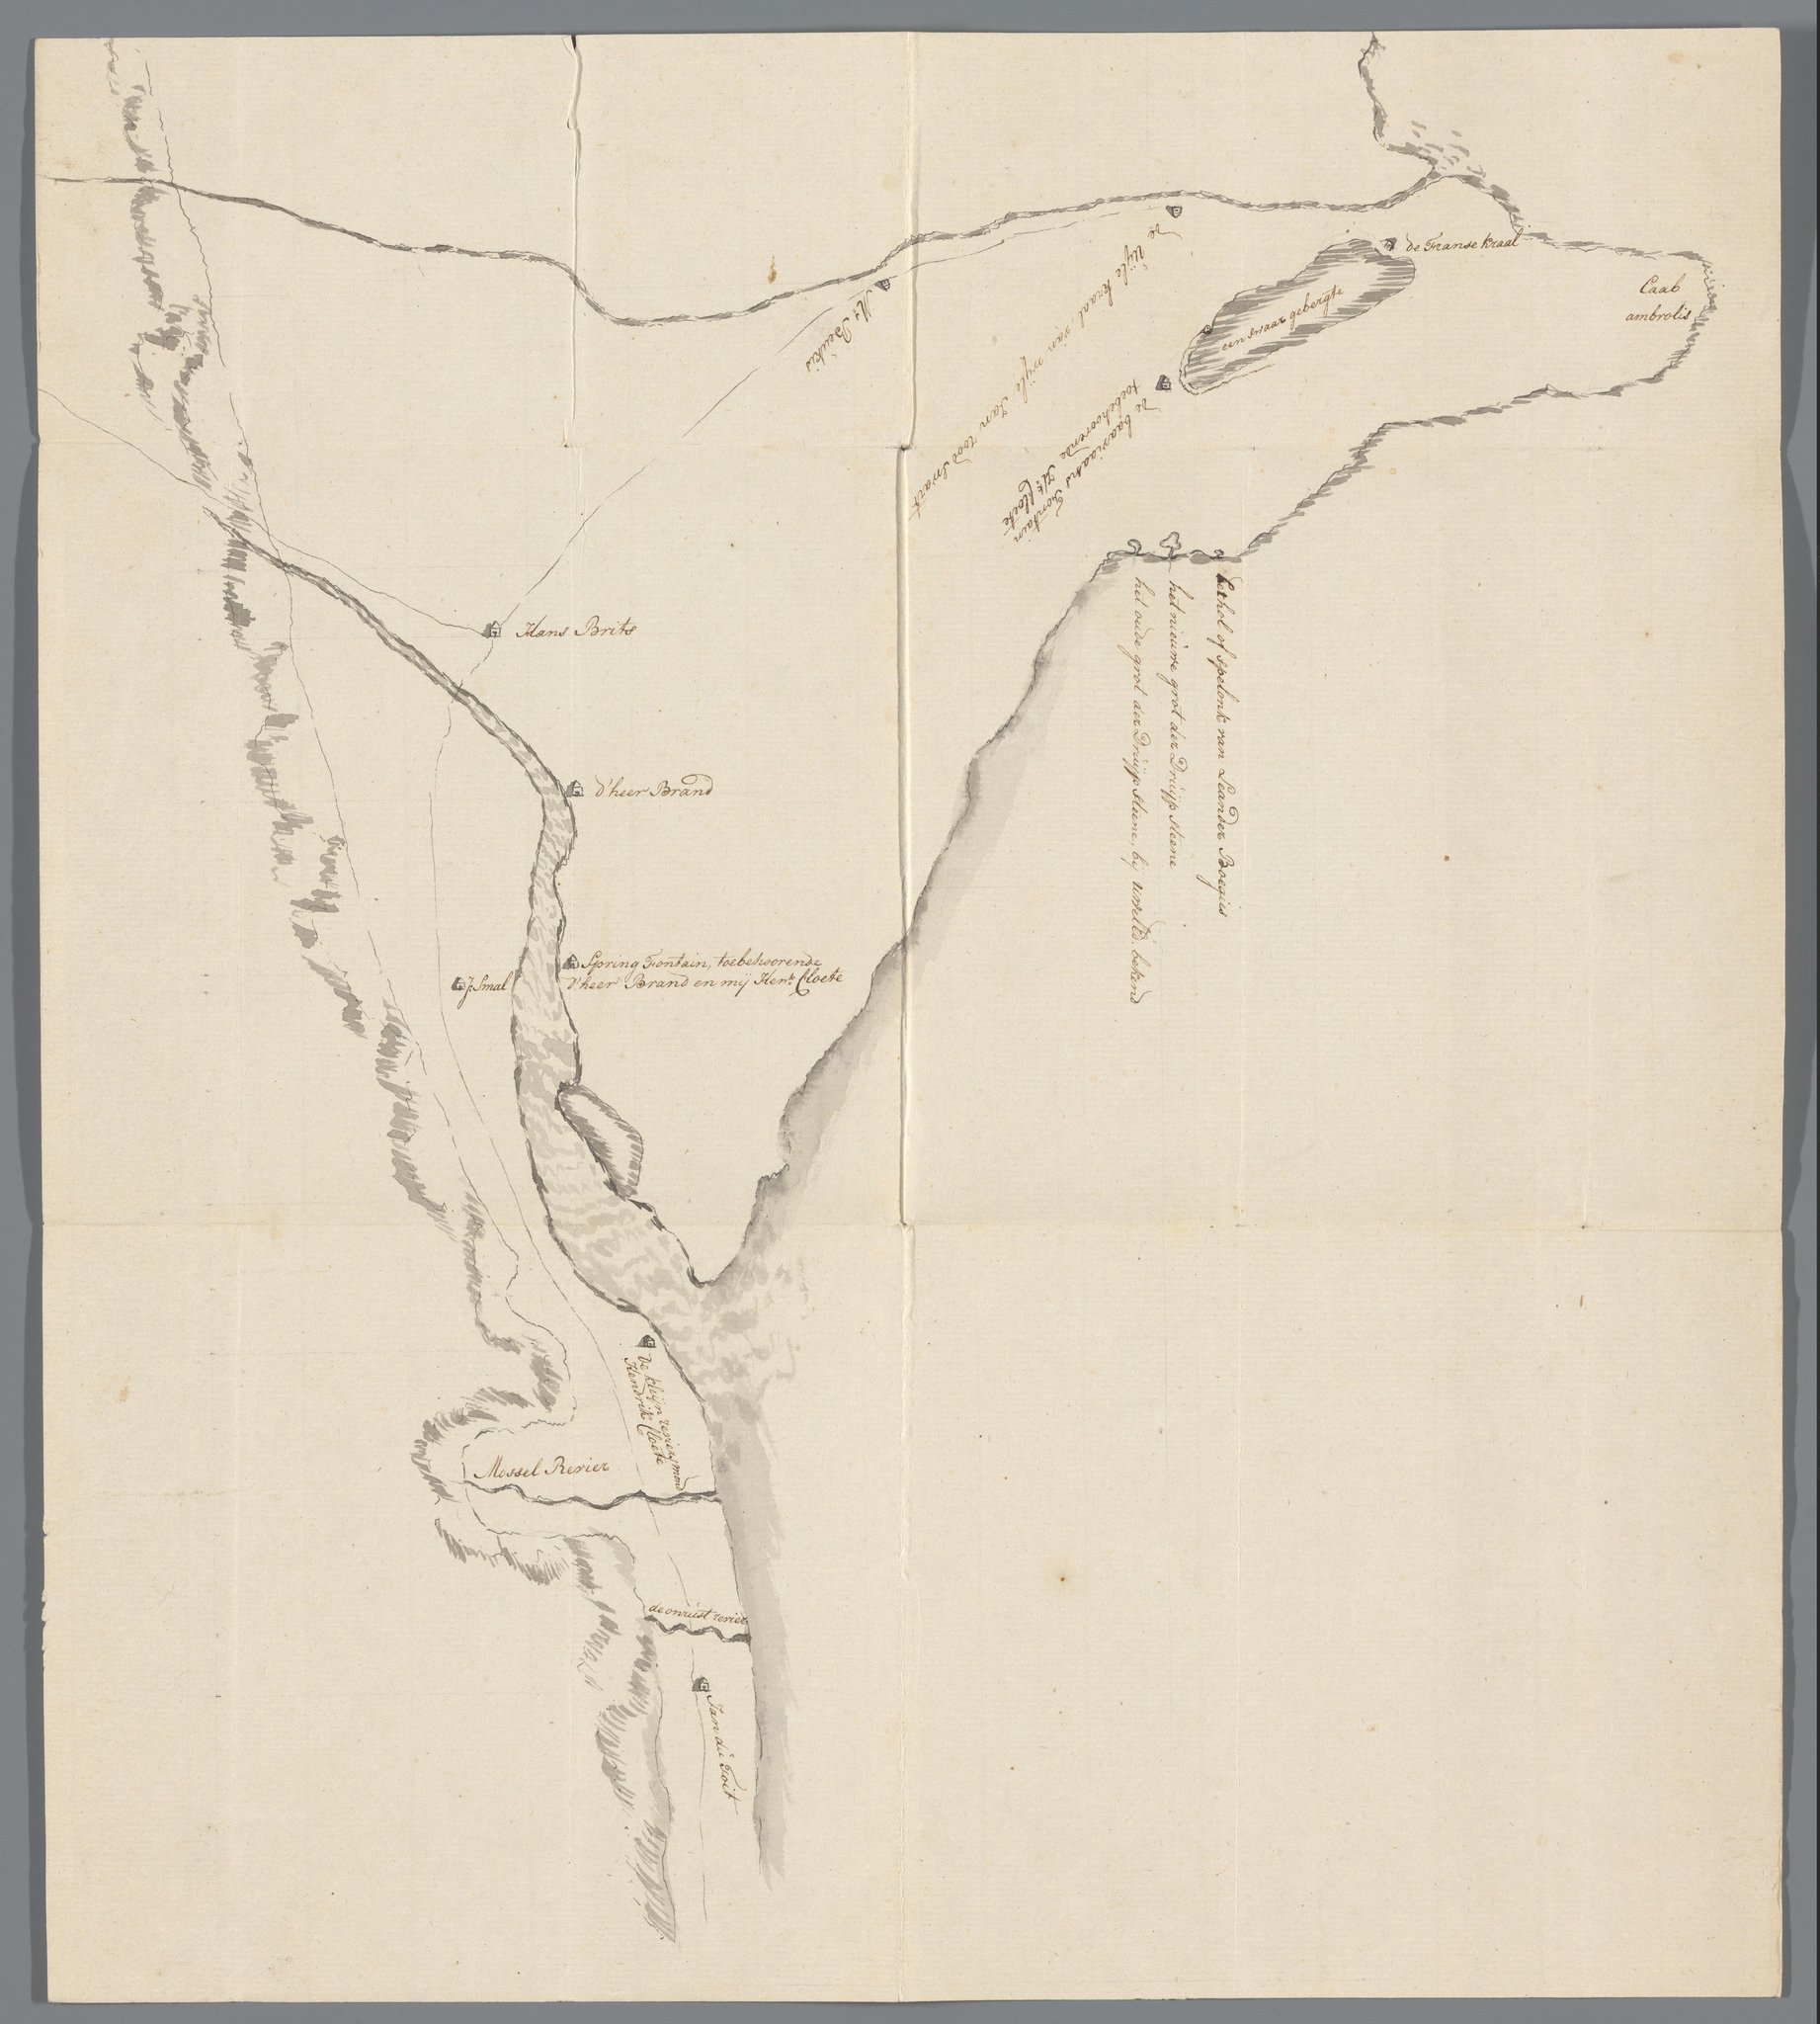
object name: drawing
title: Onderstaande is het terrein alwaar het oude Hospitaal op gestaan heeft verdeeld in 10 Huijs Erven en op 1 August 1786 (...)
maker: Anonymous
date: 1780-1799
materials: ink, paper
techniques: brush, pen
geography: south africa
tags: maps of separate countries or regions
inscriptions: label: ‘A9’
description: Getekende kaart van het kustlandschap bij het tegenwoordige Hermanus, ten oosten van Kaapstad. Op de kaart staan aangegeven namen van boerderijen, rivieren, etc. Enkele plaatsten verworven door Hendrik Cloete vanaf 1778, zoals Baviaansfontein en het terrein bij de monding van de Kleine Rivier en de Mosselrivier. Bovenaan de druipsteengrotten bij de Ambrosiushoek die door Hendrik Swellengrebel worden bezocht op 22 december tijdens zijn tweede reis naar het noordoosten van de Kaapkolonie, 10 september - 26 december 1776.